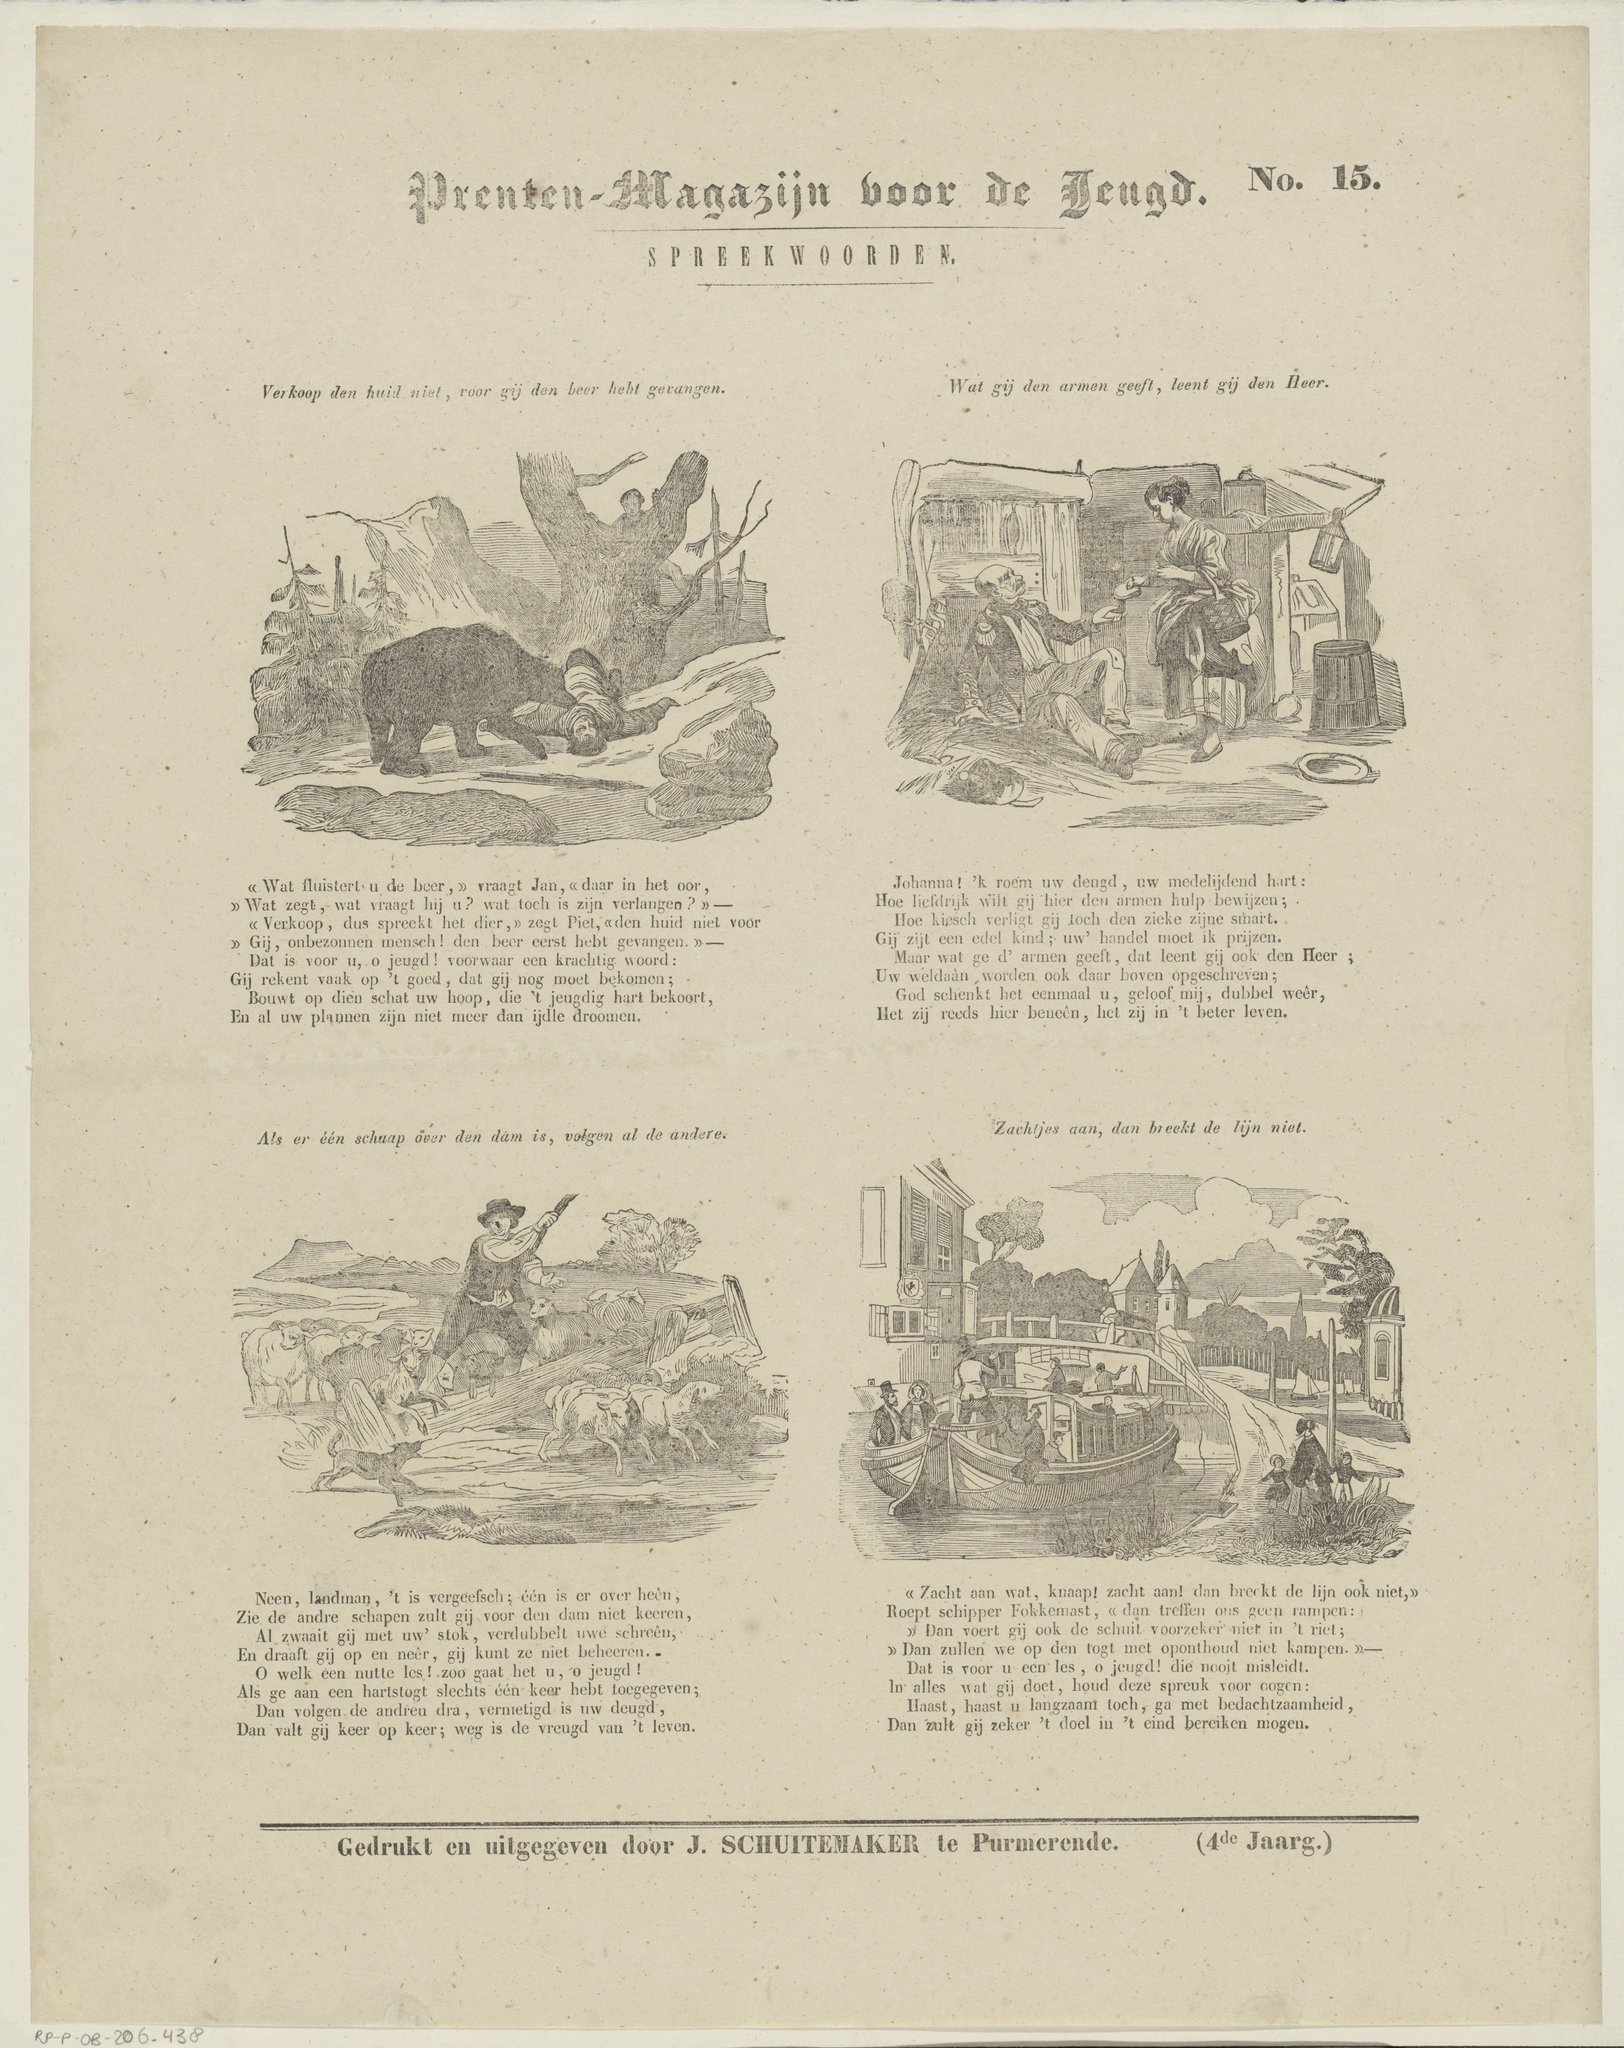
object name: popular print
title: Spreekwoorden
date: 1845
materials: paper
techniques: letterpress printing, engraving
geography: purmerend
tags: proverbs, sayings, etc.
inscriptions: collector's mark: Lugt 2760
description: Blad met 4 verbeeldingen van spreekwoorden. Boven elke voorstelling een titel en onder elke voorstelling een achtregelig vers. Genummerd rechtsboven: No. 15.